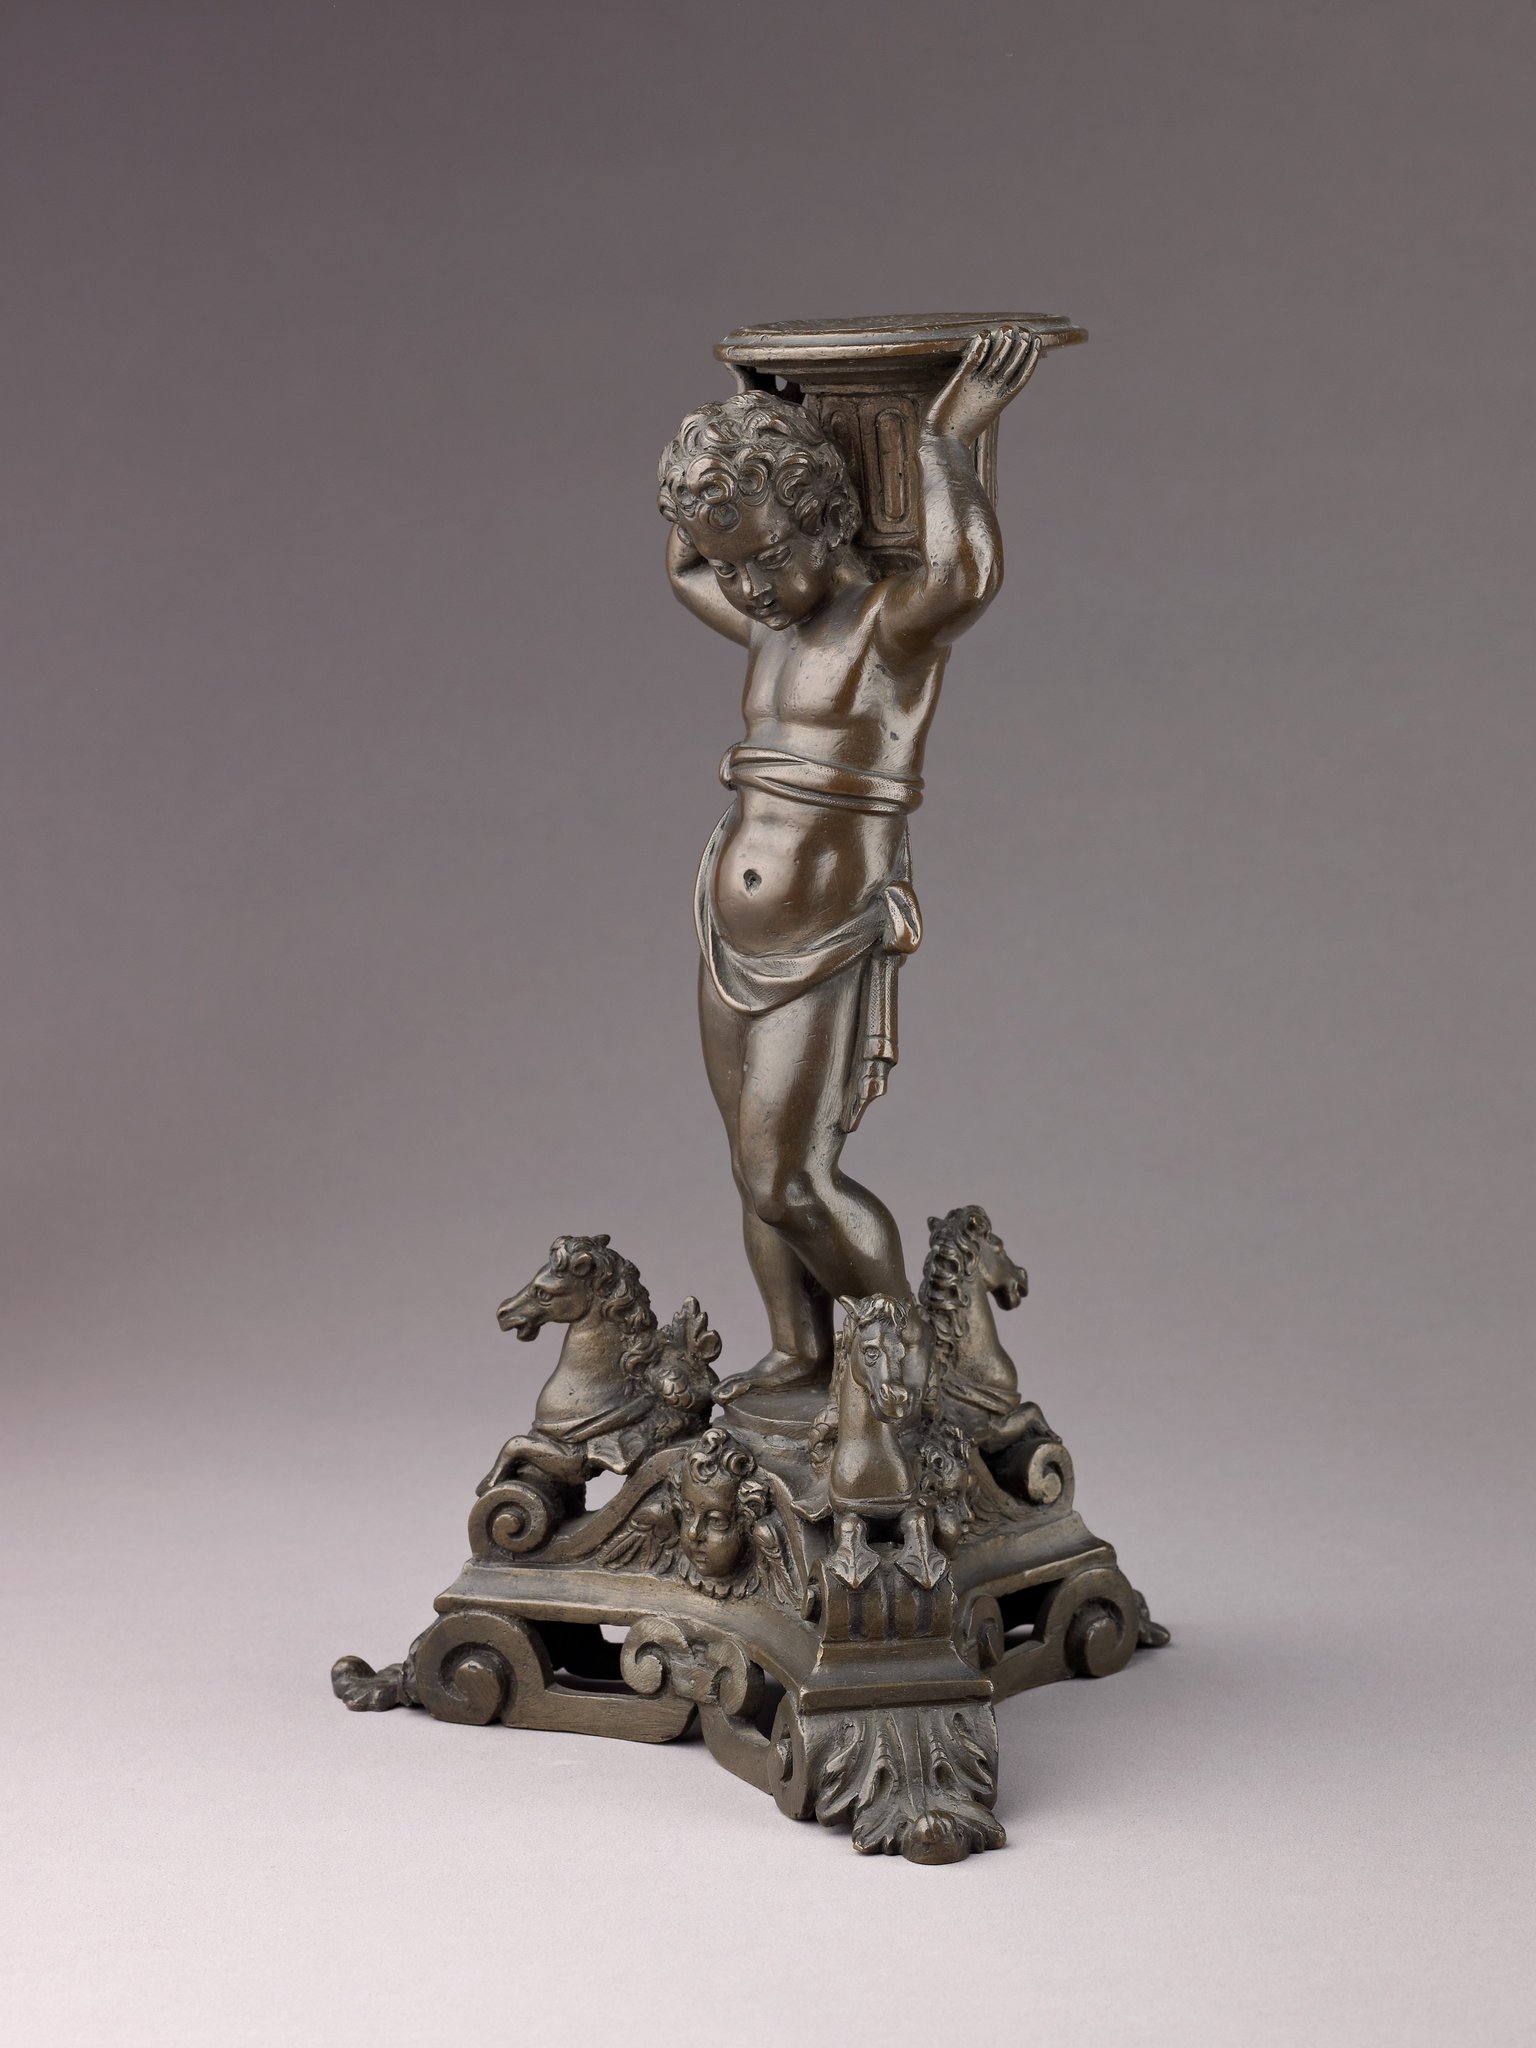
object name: candlestick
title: Candlestick in the form of a Putto (see also 1975.1.1374, .1376, .1377)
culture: italian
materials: bronze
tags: putti,horses